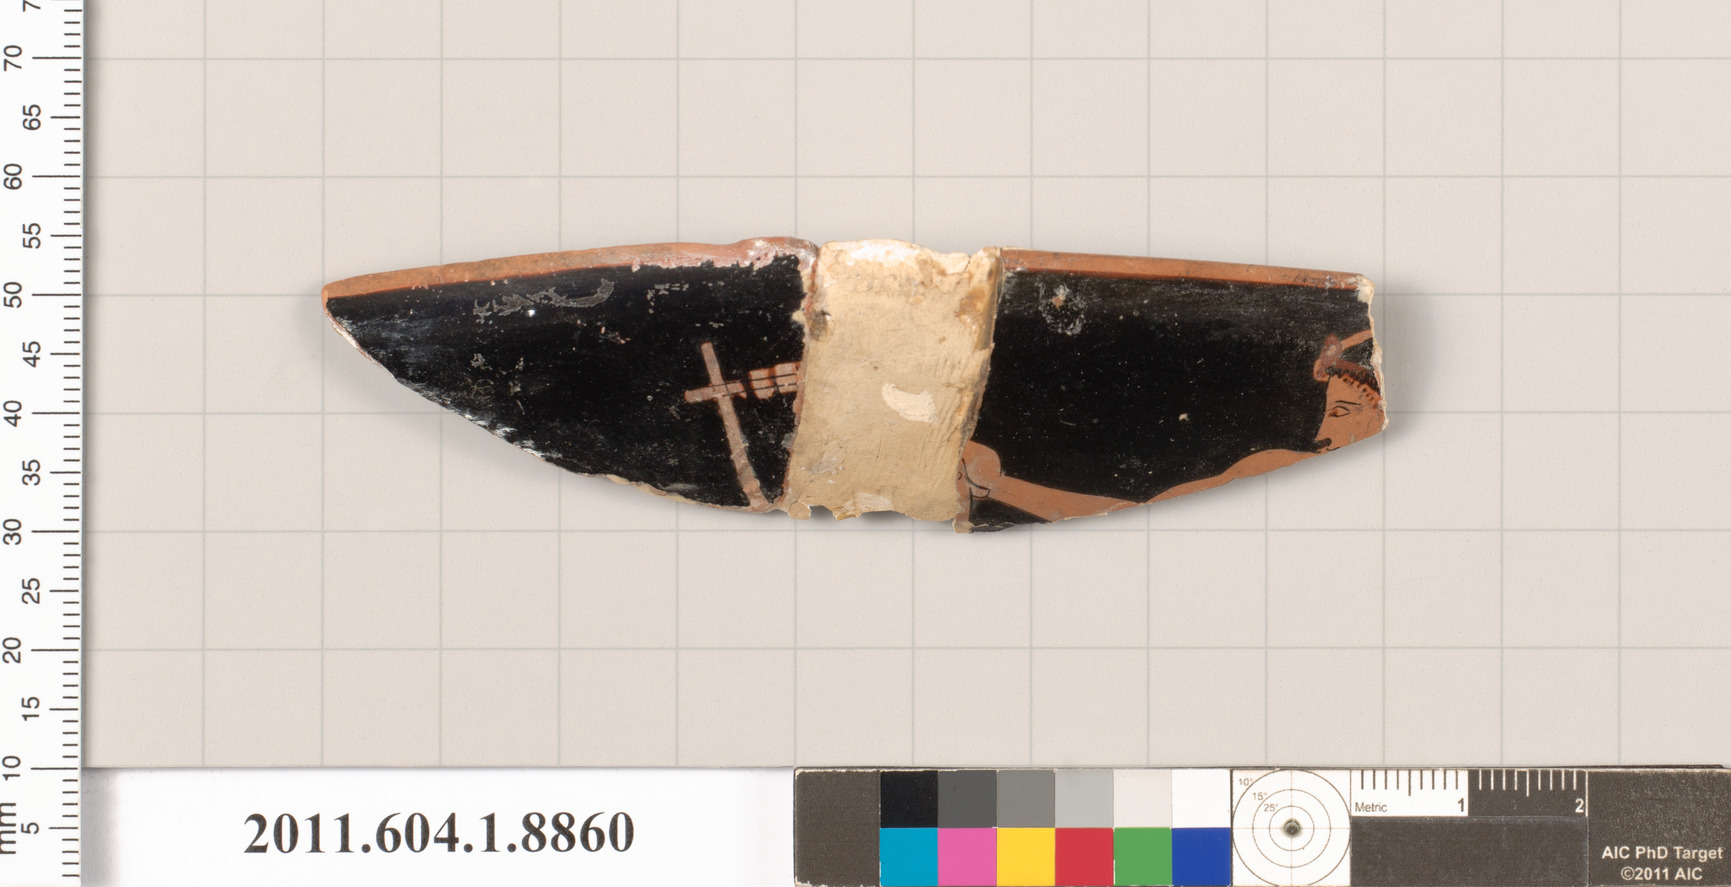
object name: kylix fragment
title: Terracotta rim fragment of a kylix (drinking cup)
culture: greek, attic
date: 460-450 BCE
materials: terracotta